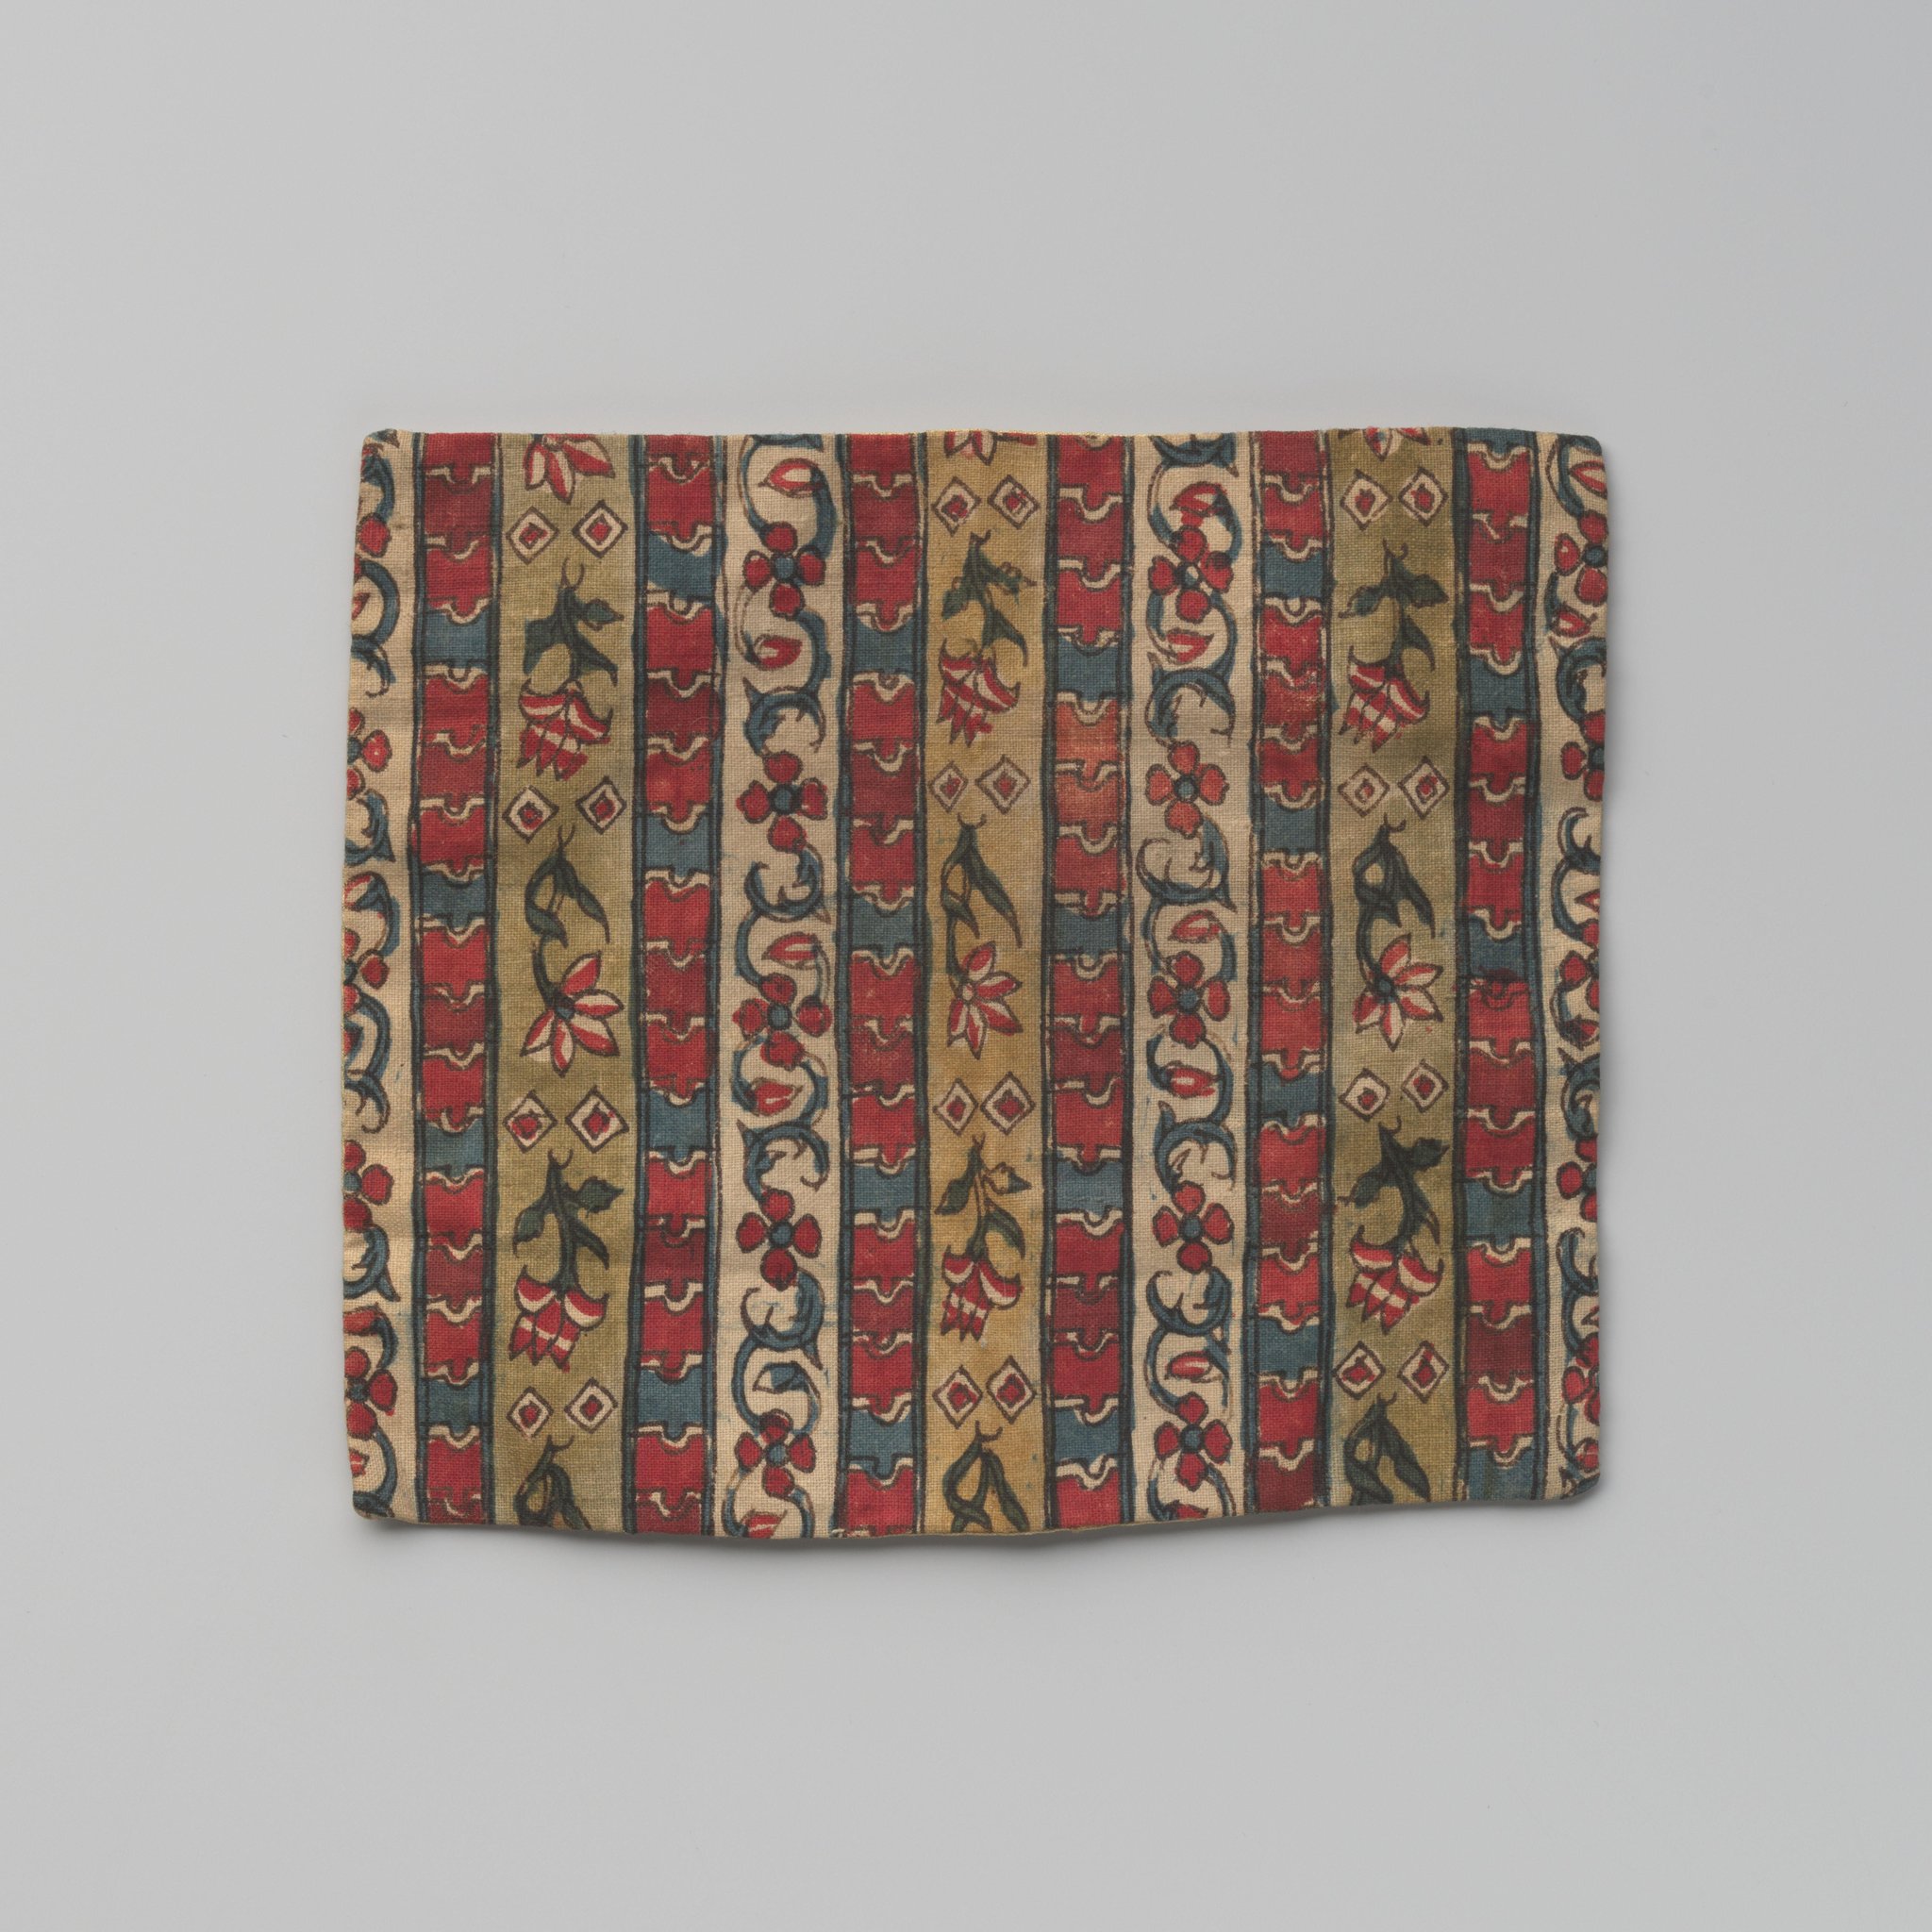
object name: miniature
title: Sprei van beschilderde katoen (sits), gevoerd met lichtgele zijde.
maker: Anonymous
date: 1690-1710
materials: cotton, silk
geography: india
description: Sprei van beschilderde katoen (sits), gevoerd met lichtgele zijde, zonder tussenlaag; dessin gestreept met gestileerde motieven van bloemen, blokjes en schulpen, in blauw, rood, geel, donkerrood.